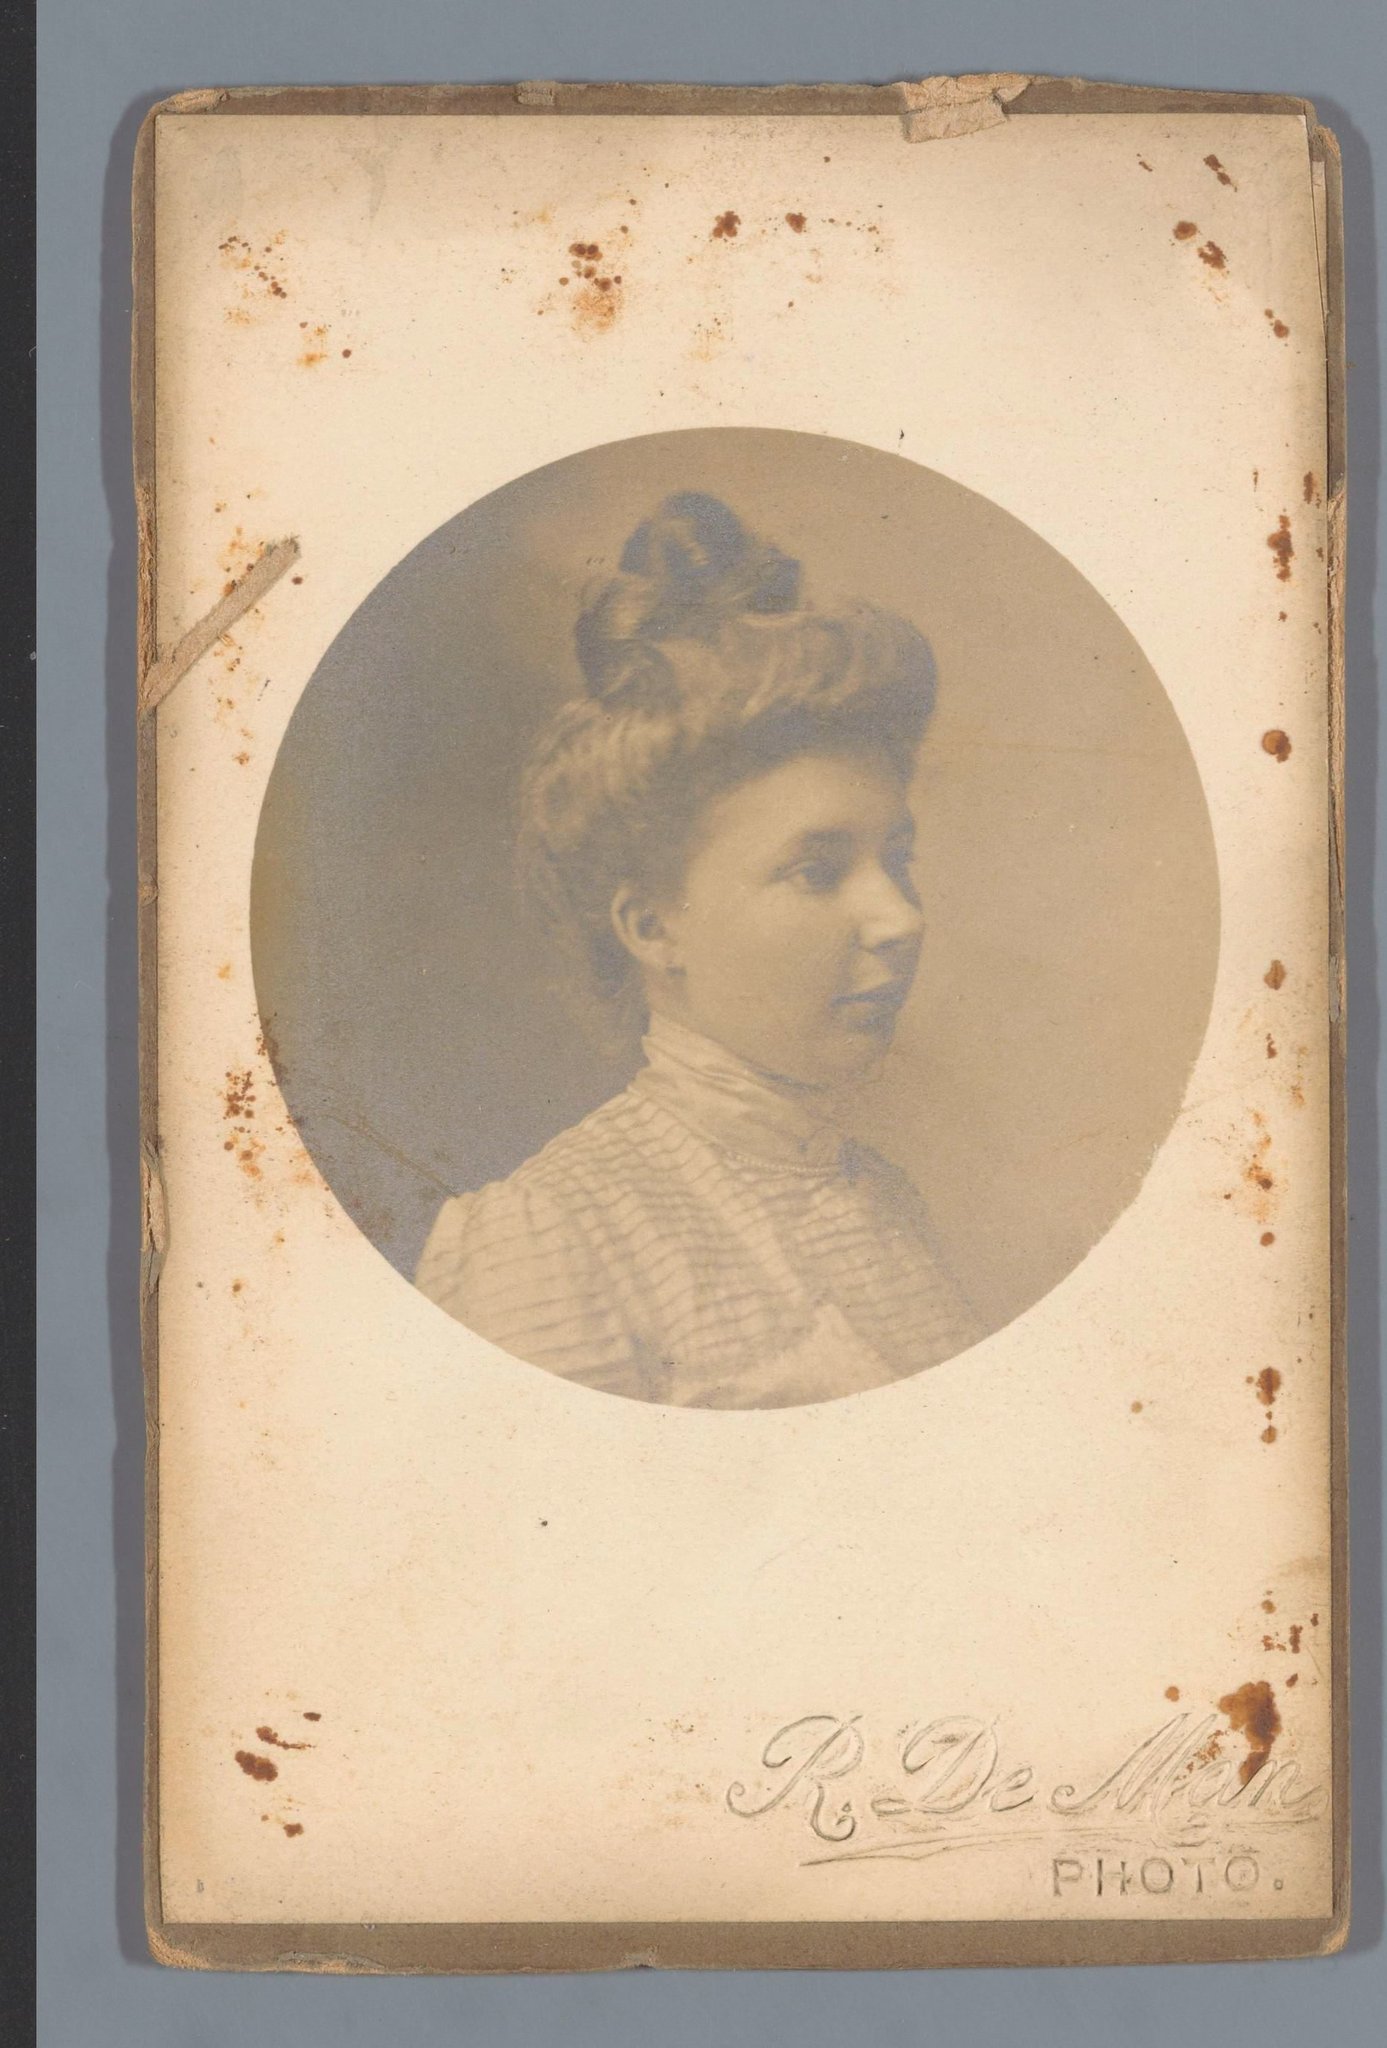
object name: photograph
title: Portret van een onbekende vrouw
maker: rené de man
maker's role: fotograaf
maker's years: 1848-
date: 1865-1900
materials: photographic support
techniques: gelatin silver print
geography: brussels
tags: adolescent, young woman, maiden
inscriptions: name: ‘R. De Man Photo.’